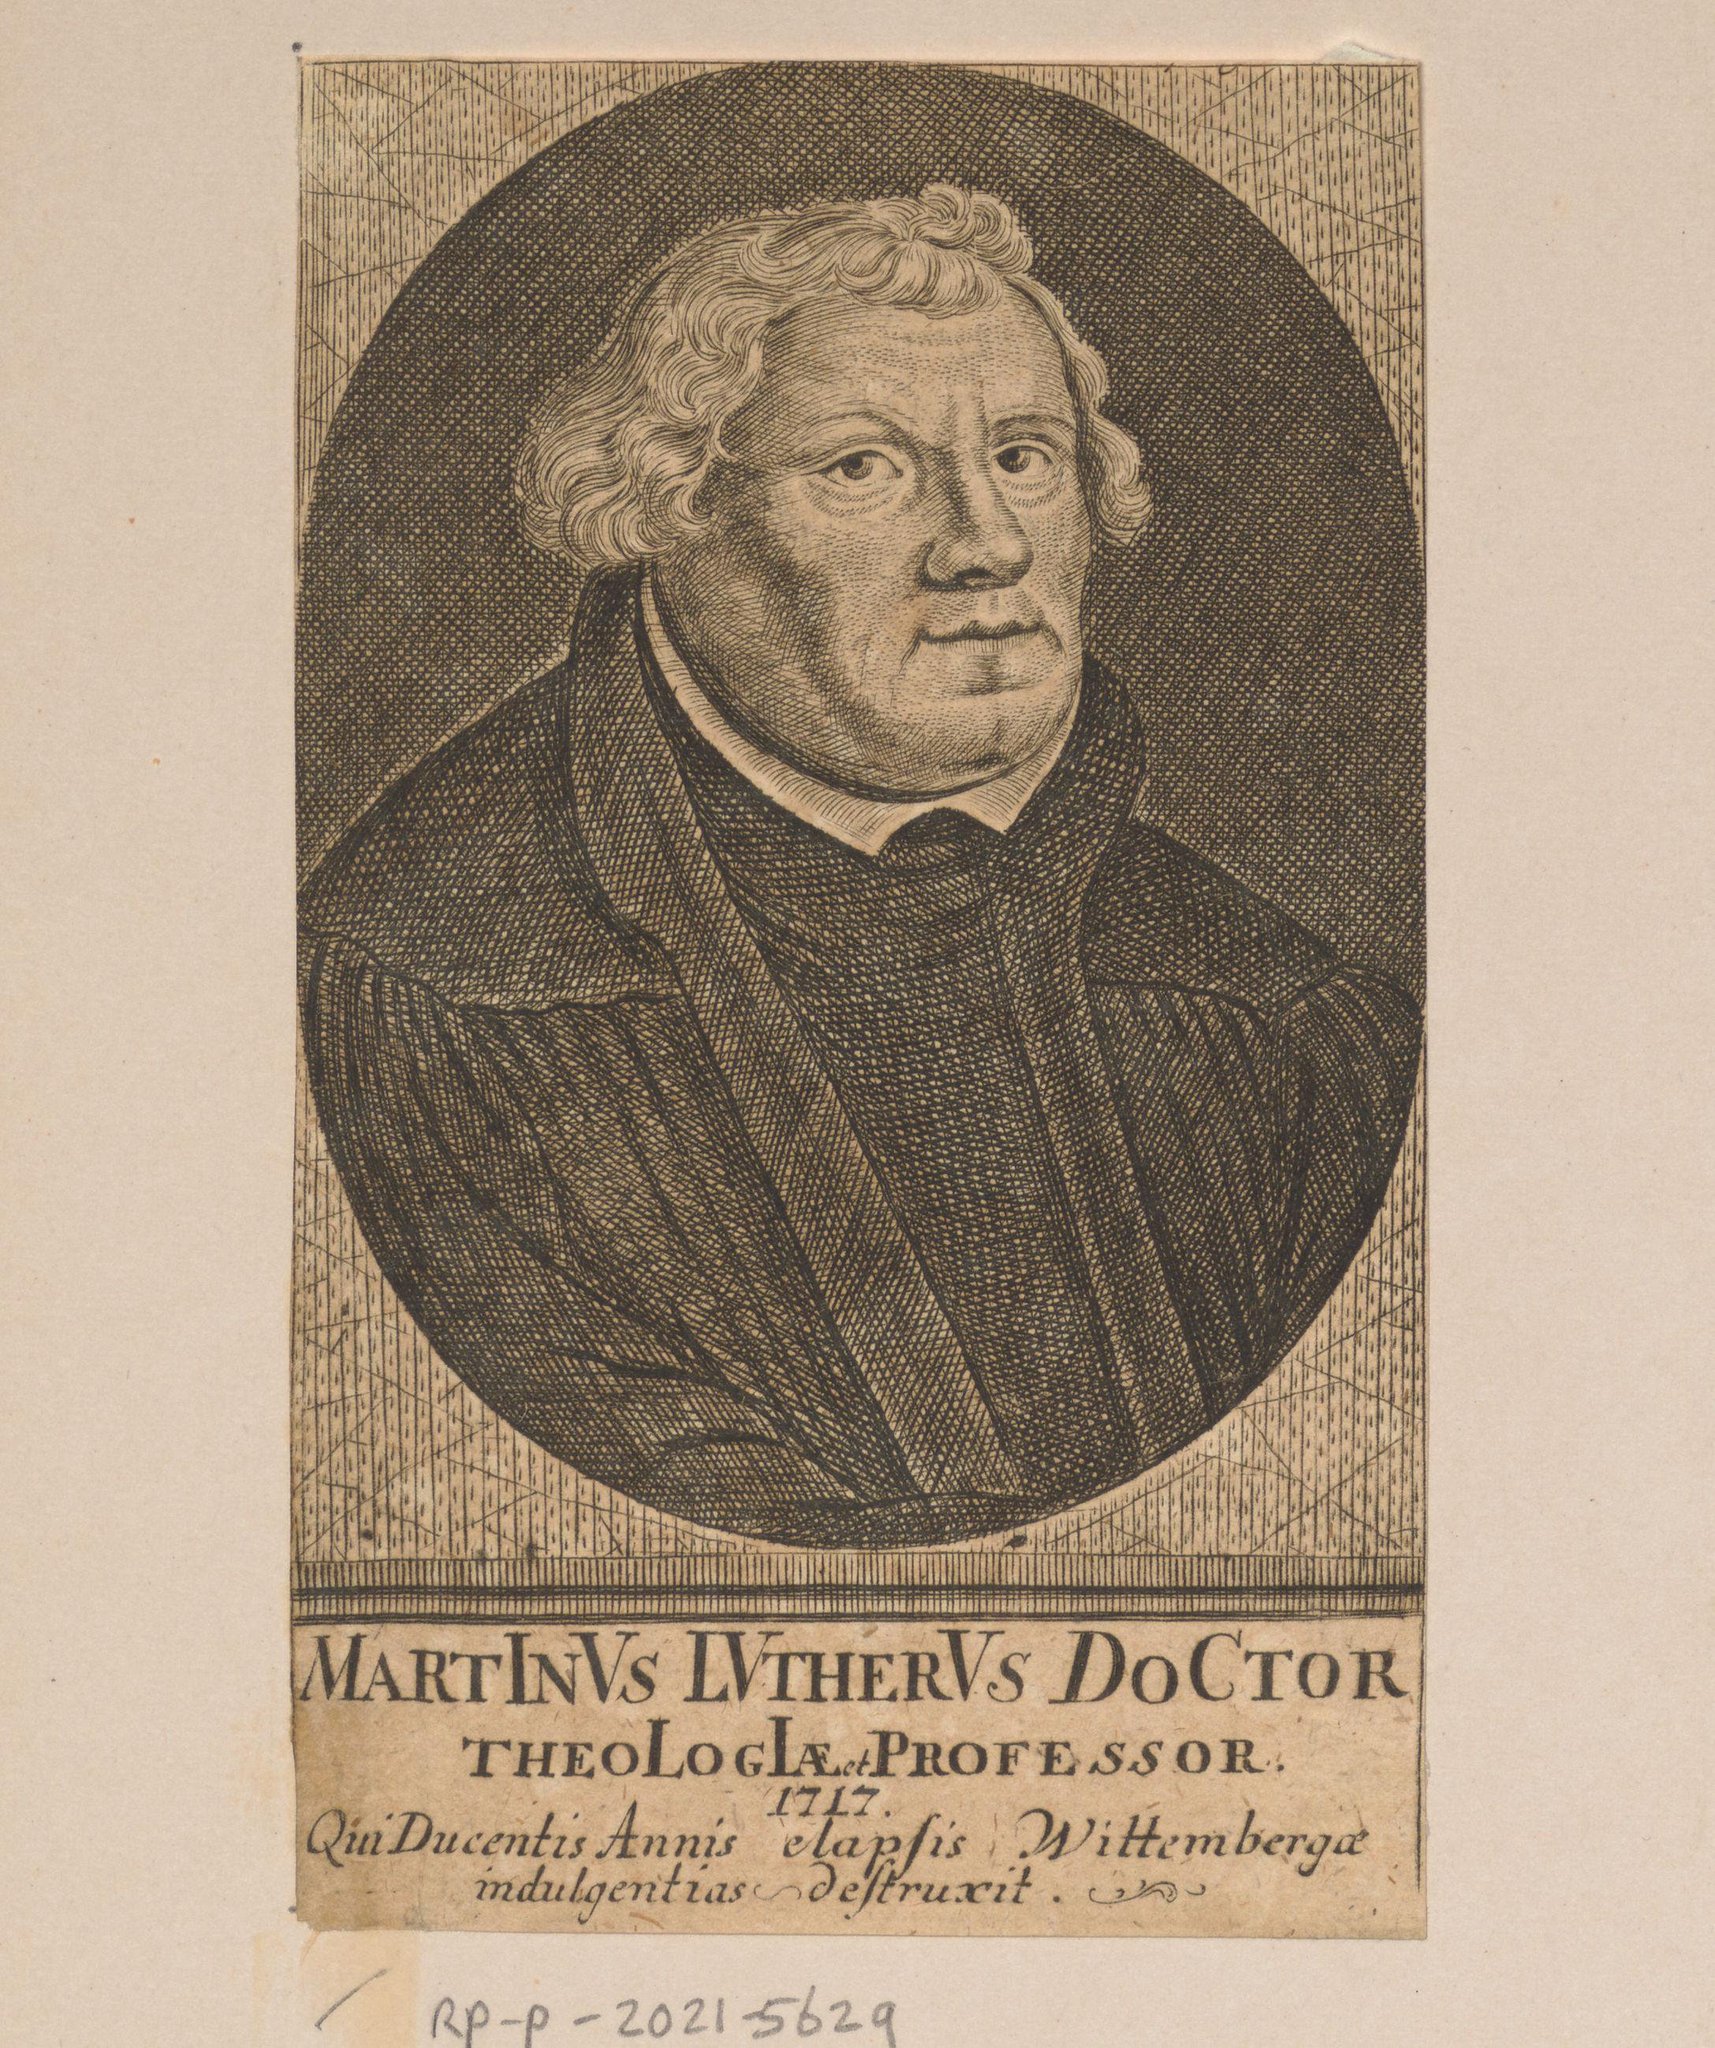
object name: print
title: Portret van Martin Luther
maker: Anonymous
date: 1717-1720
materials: paper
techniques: engraving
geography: germany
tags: martin luther, theologian, historical persons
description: Prent waarschijnlijk uit: Curieuser Geschichts-Calender, Des Hocherleuchteten und von Gott zur Verbesserung der Christlichen Kirchen auserwehlten Mannes D. Martini Lutheri (...). Leipzig: Jacob Schuster, 1720.